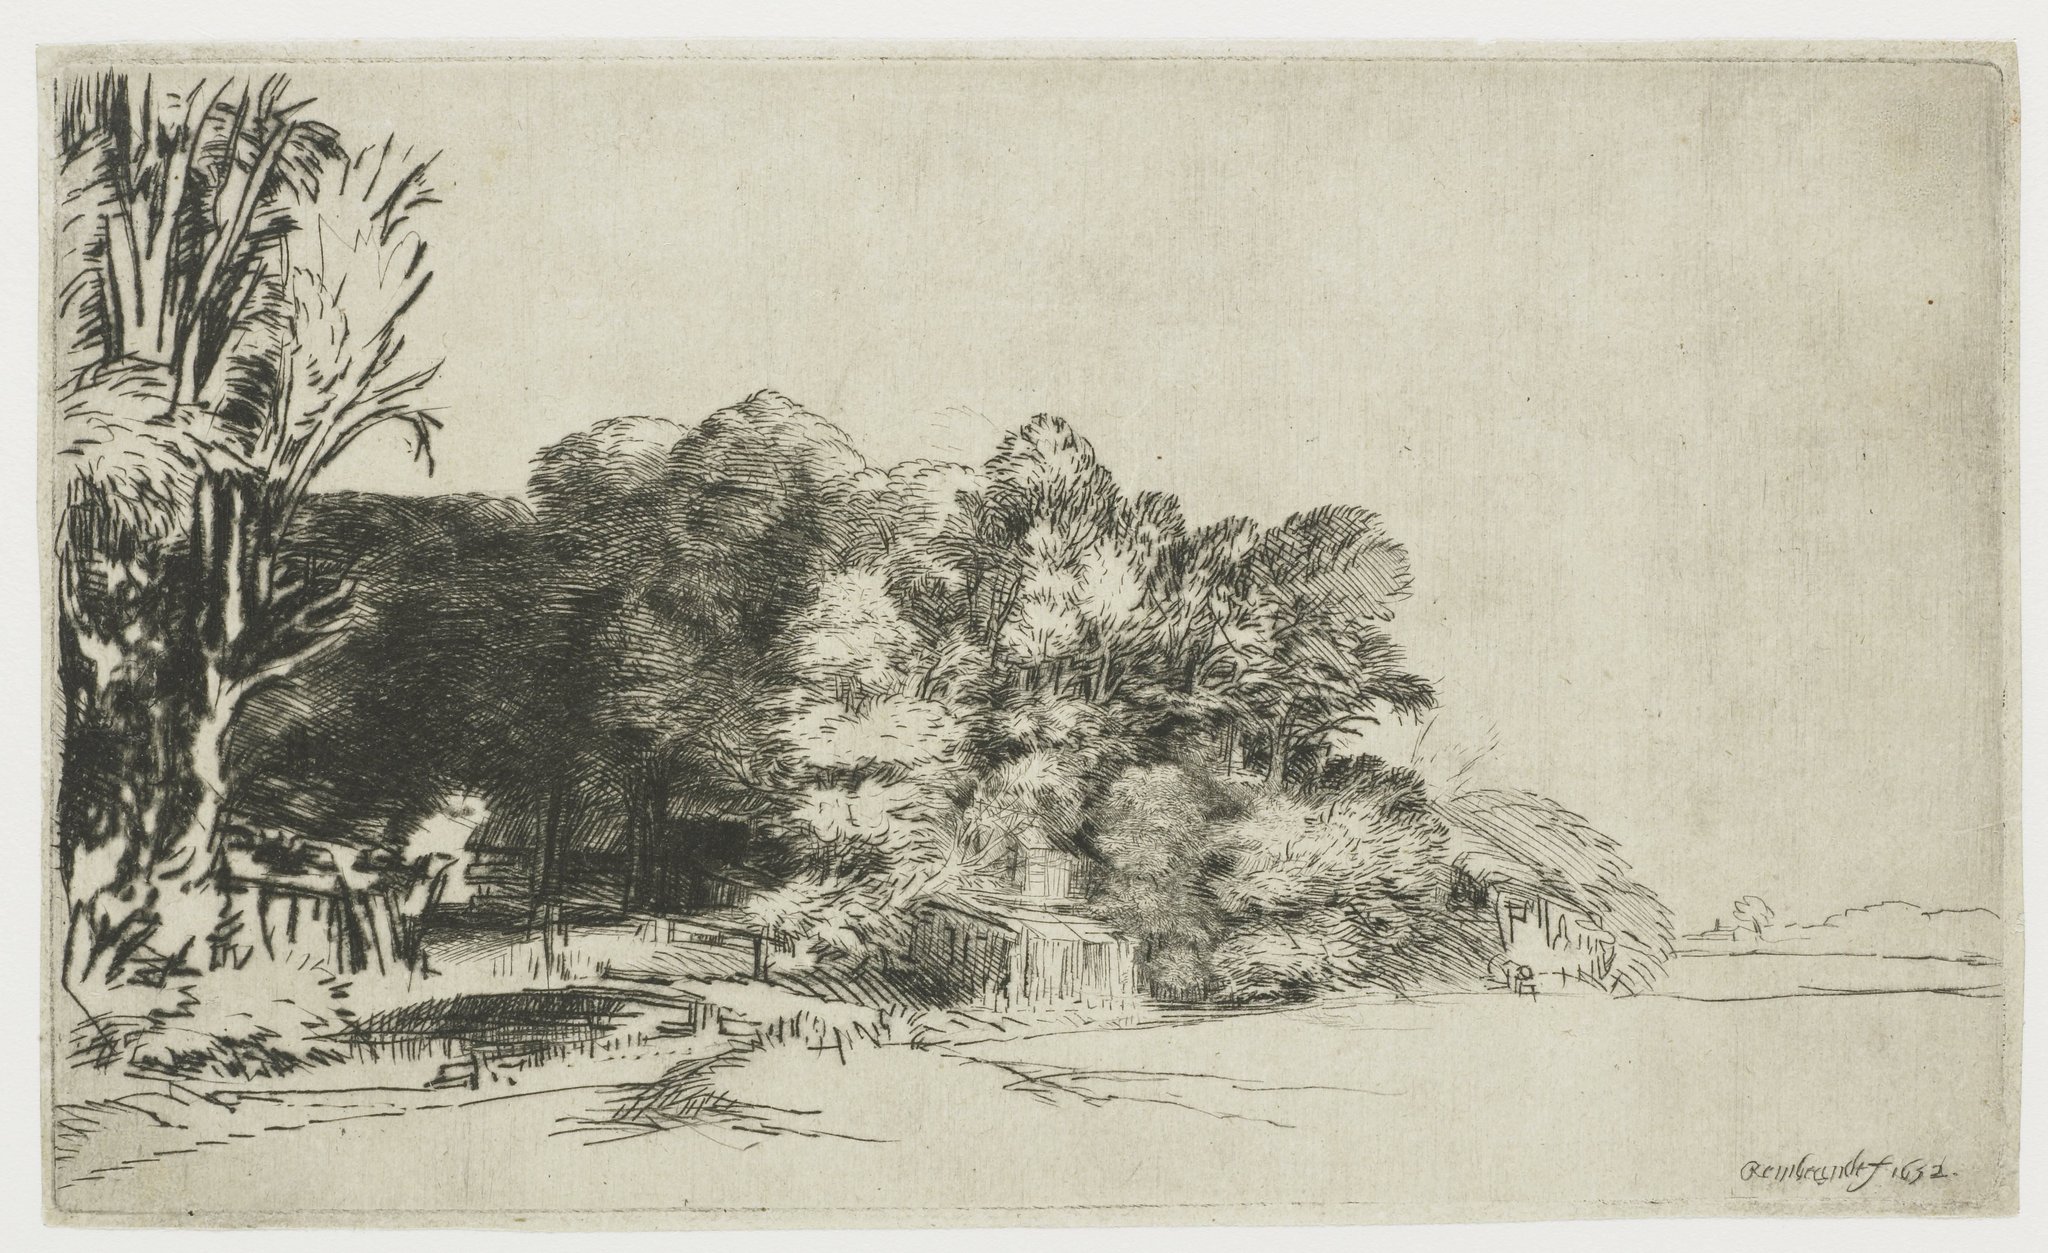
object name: print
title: Clump of trees with a vista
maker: rembrandt van rijn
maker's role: draughtsman, painter, print maker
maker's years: 1606-1669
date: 1652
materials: ink, paper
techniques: drypoint, pen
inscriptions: mark: ‘Massaloff 1865’ Lugt 1802, mark: Lugt 2228, mark: ‘tekst in het russisch en nummer N 40592 (in potlood)’, signature: ‘Rembrandt f 1652’